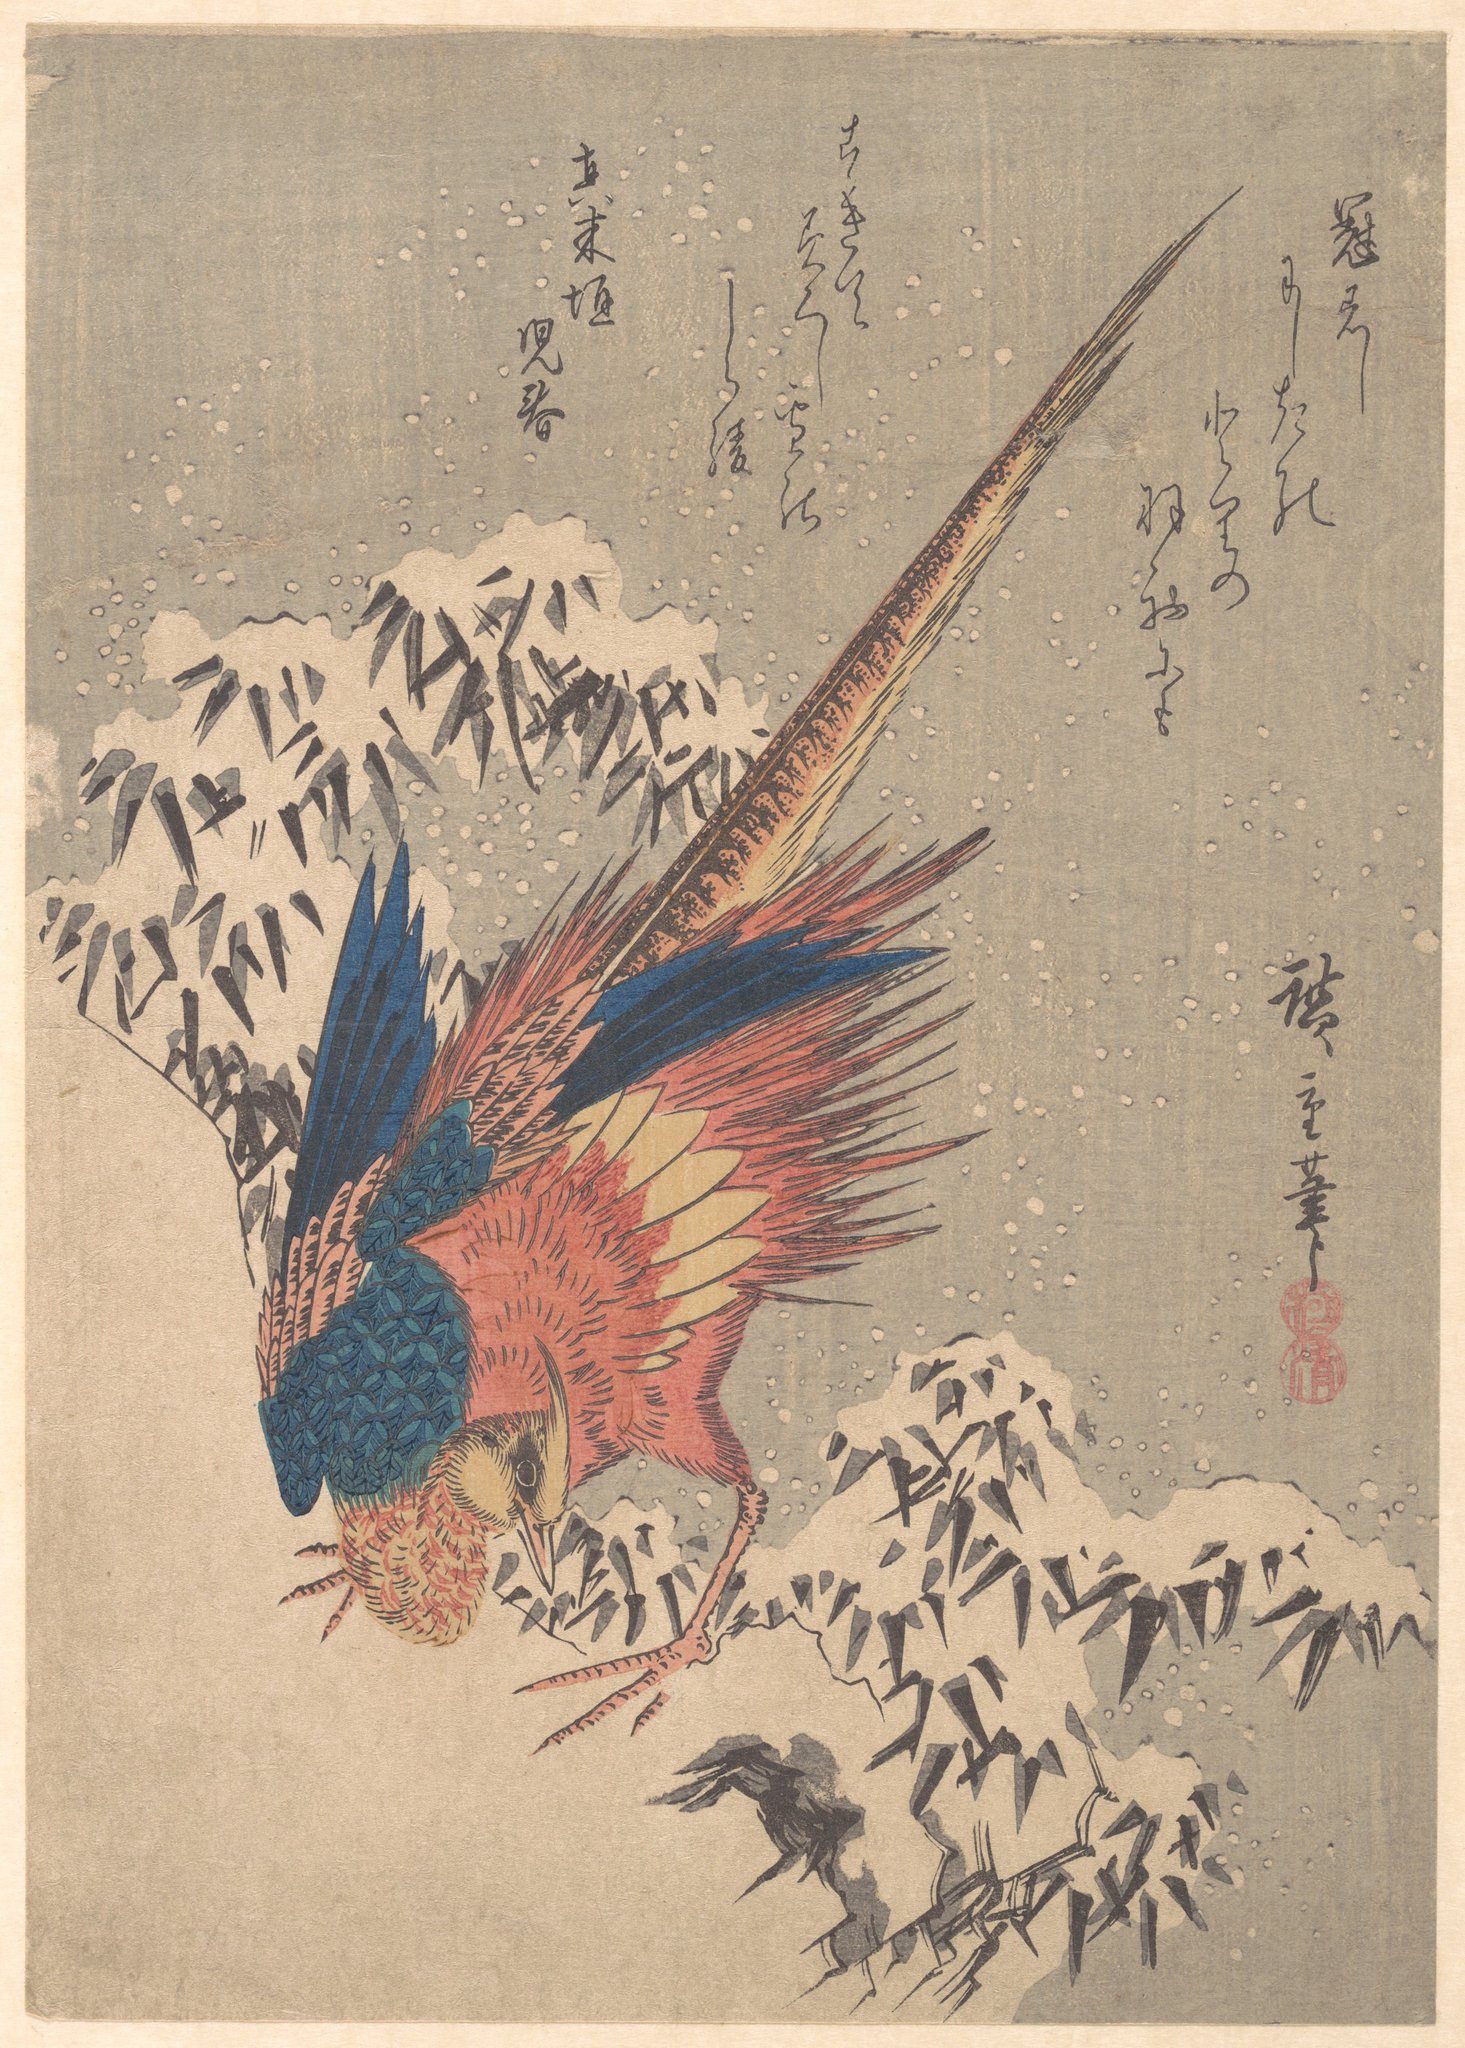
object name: print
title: Pheasant Among Snow–laden Bamboo on Hillside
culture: japanese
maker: utagawa hiroshige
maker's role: artist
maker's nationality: japanese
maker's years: 1797-1858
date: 1840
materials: ink, paper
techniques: woodblock print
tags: pheasants,snow